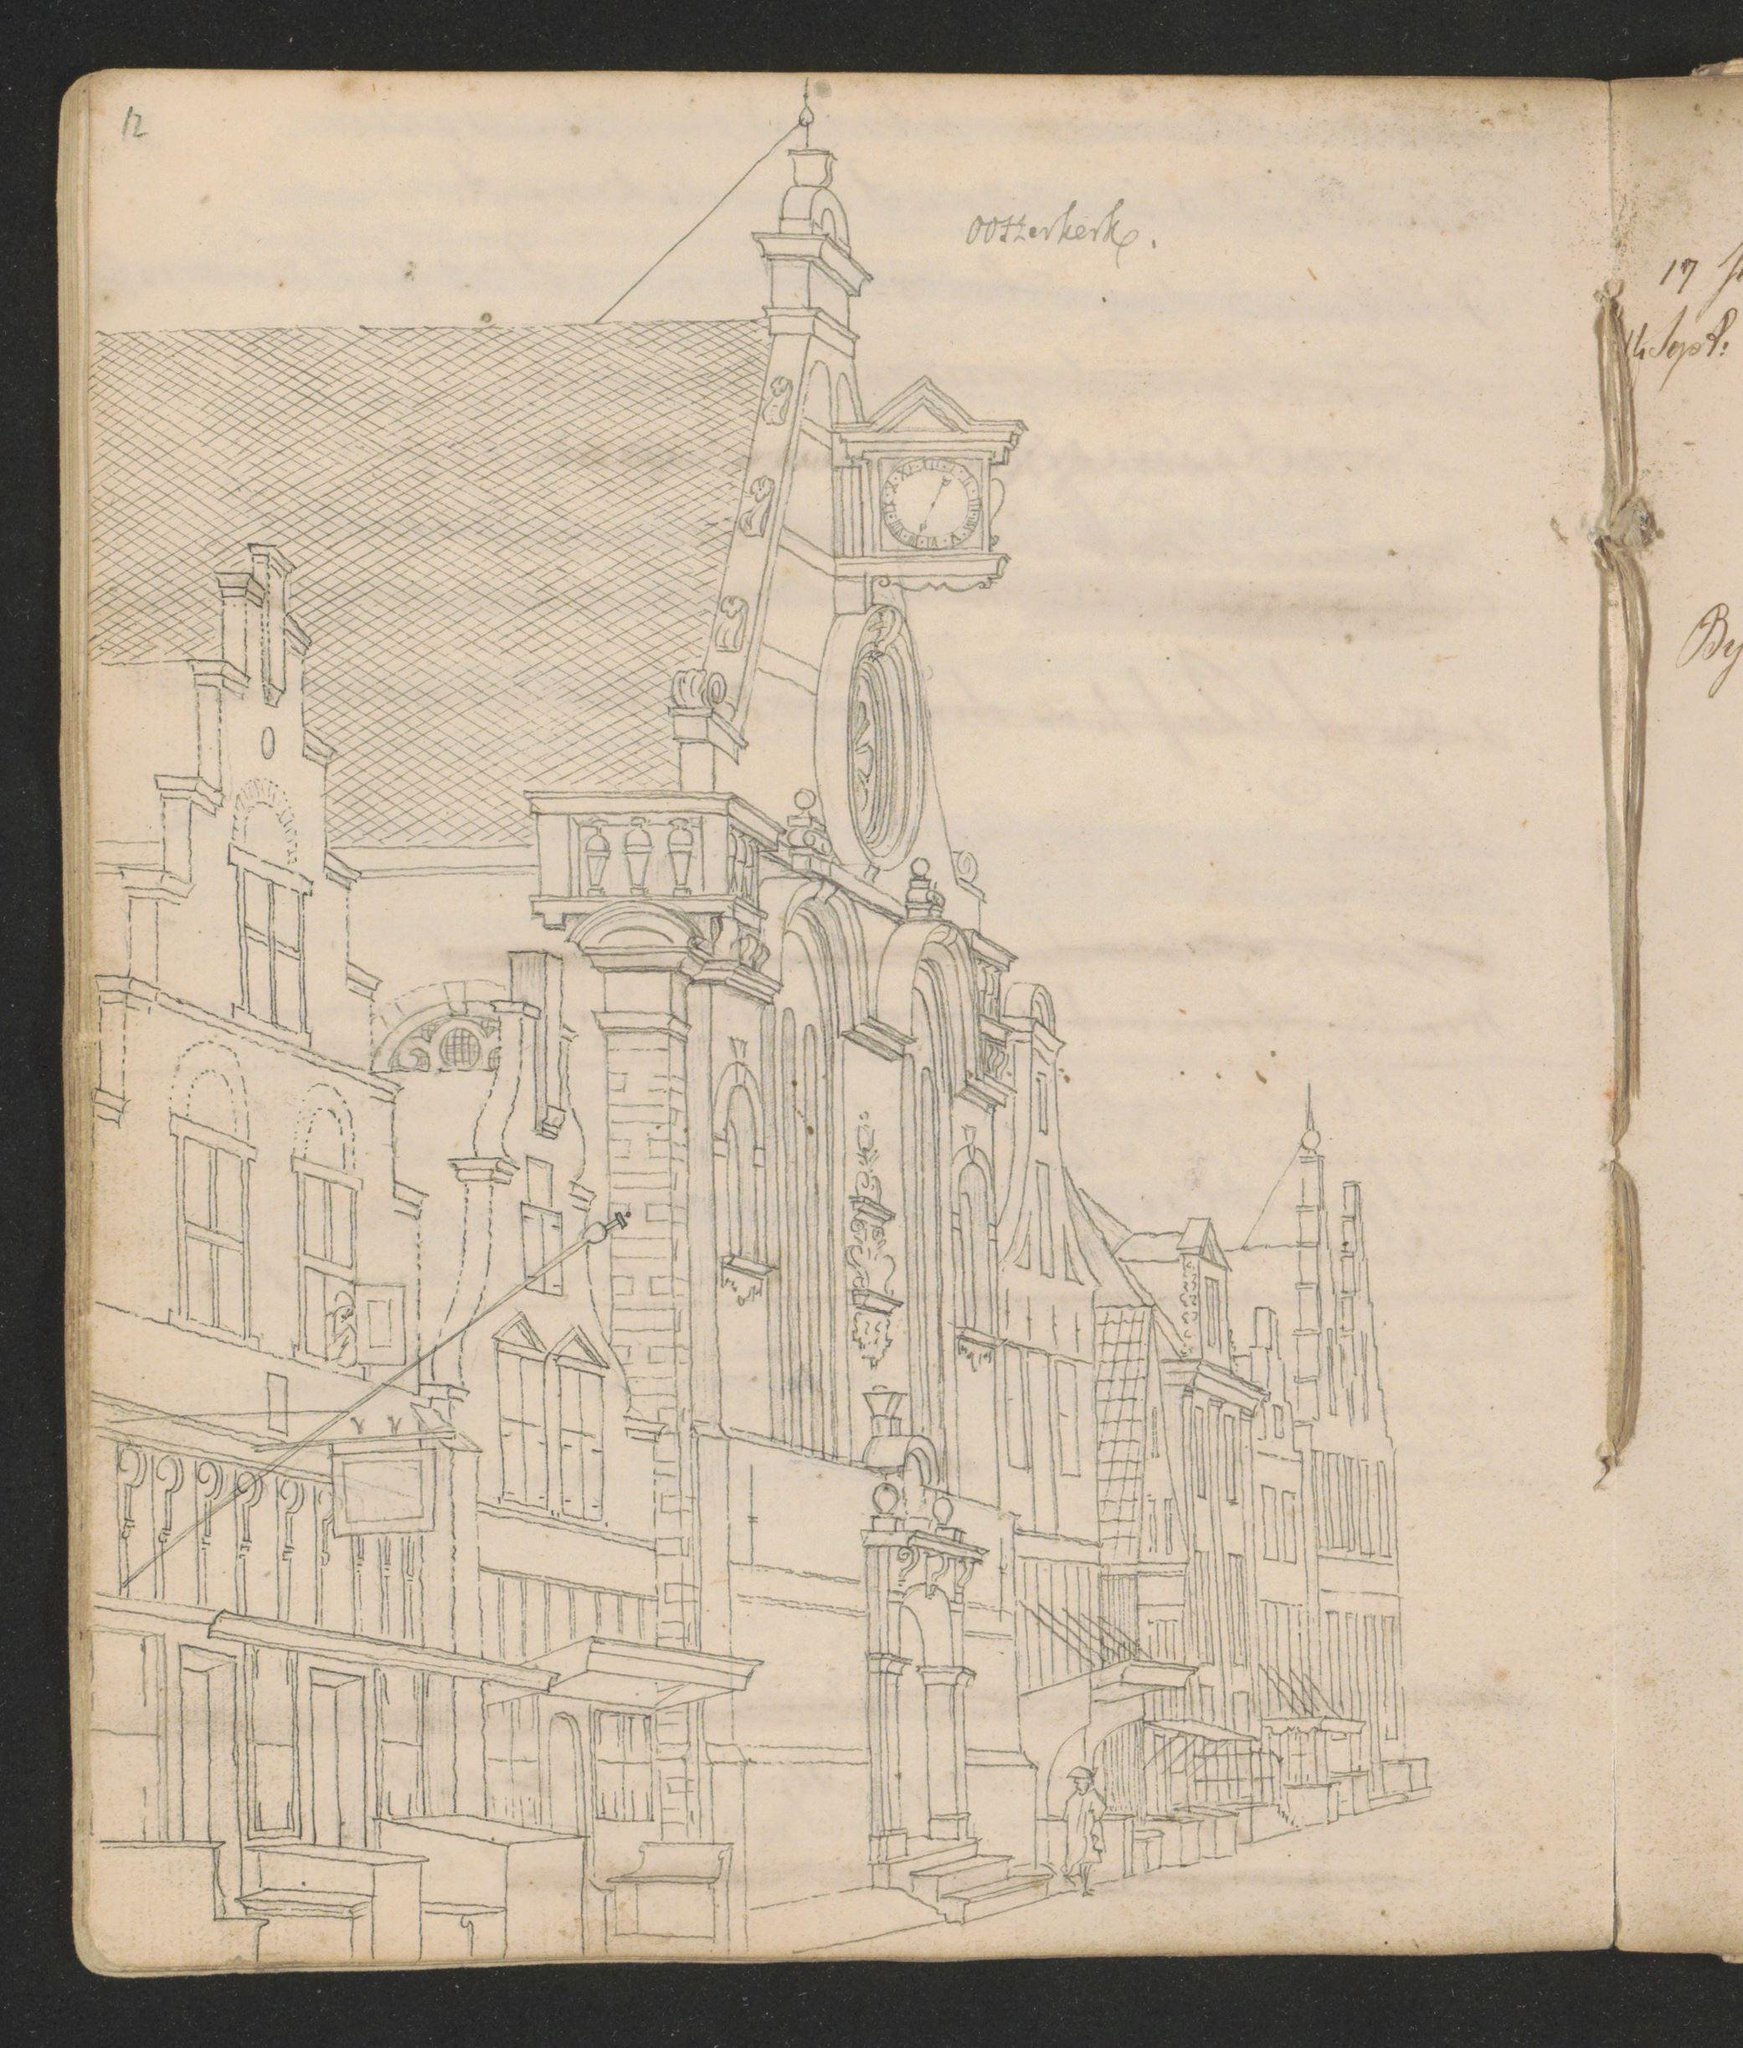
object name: sketchbook leaf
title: Oosterkerk te Hoorn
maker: cornelis pronk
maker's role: draughtsman, painter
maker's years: 1691-1759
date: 1728-1732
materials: ink, paper, pencil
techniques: pen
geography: hoorn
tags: church (exterior)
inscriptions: annotation: ‘Oosterkerk.’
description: Bladzijde 12 uit een schetsboek met 96 bladzijden.